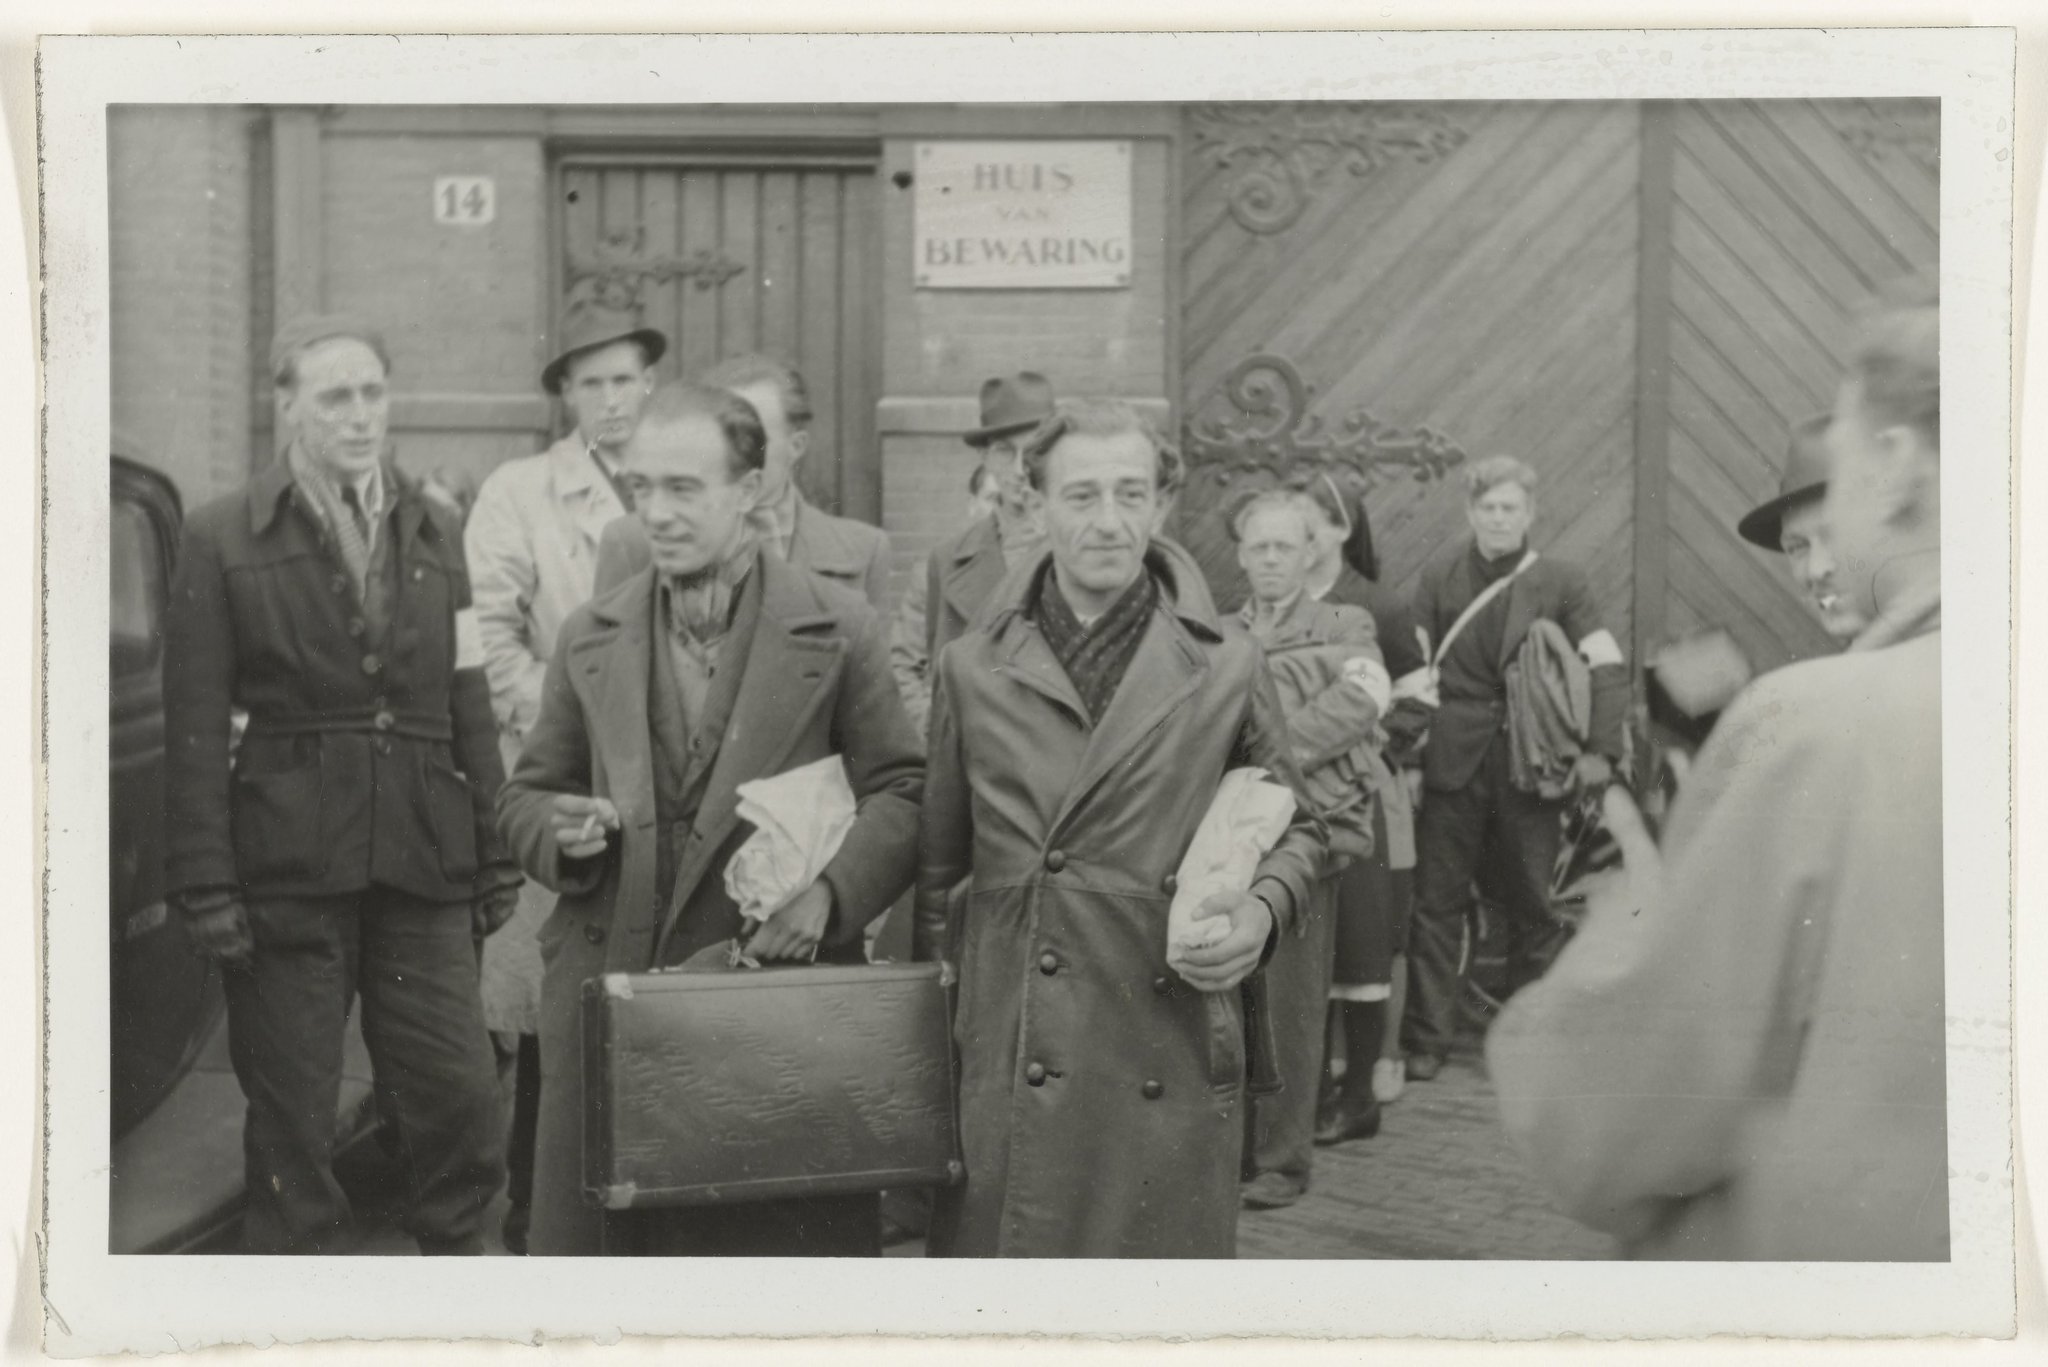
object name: photograph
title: Gevangenen verlaten het Huis van Bewaring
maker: Anonymous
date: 1945-1946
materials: photographic support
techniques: photography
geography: amsterdam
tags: amsterdam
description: Een groep mannen, ex- gevangenen, verlaten het Huis van Bewaring.